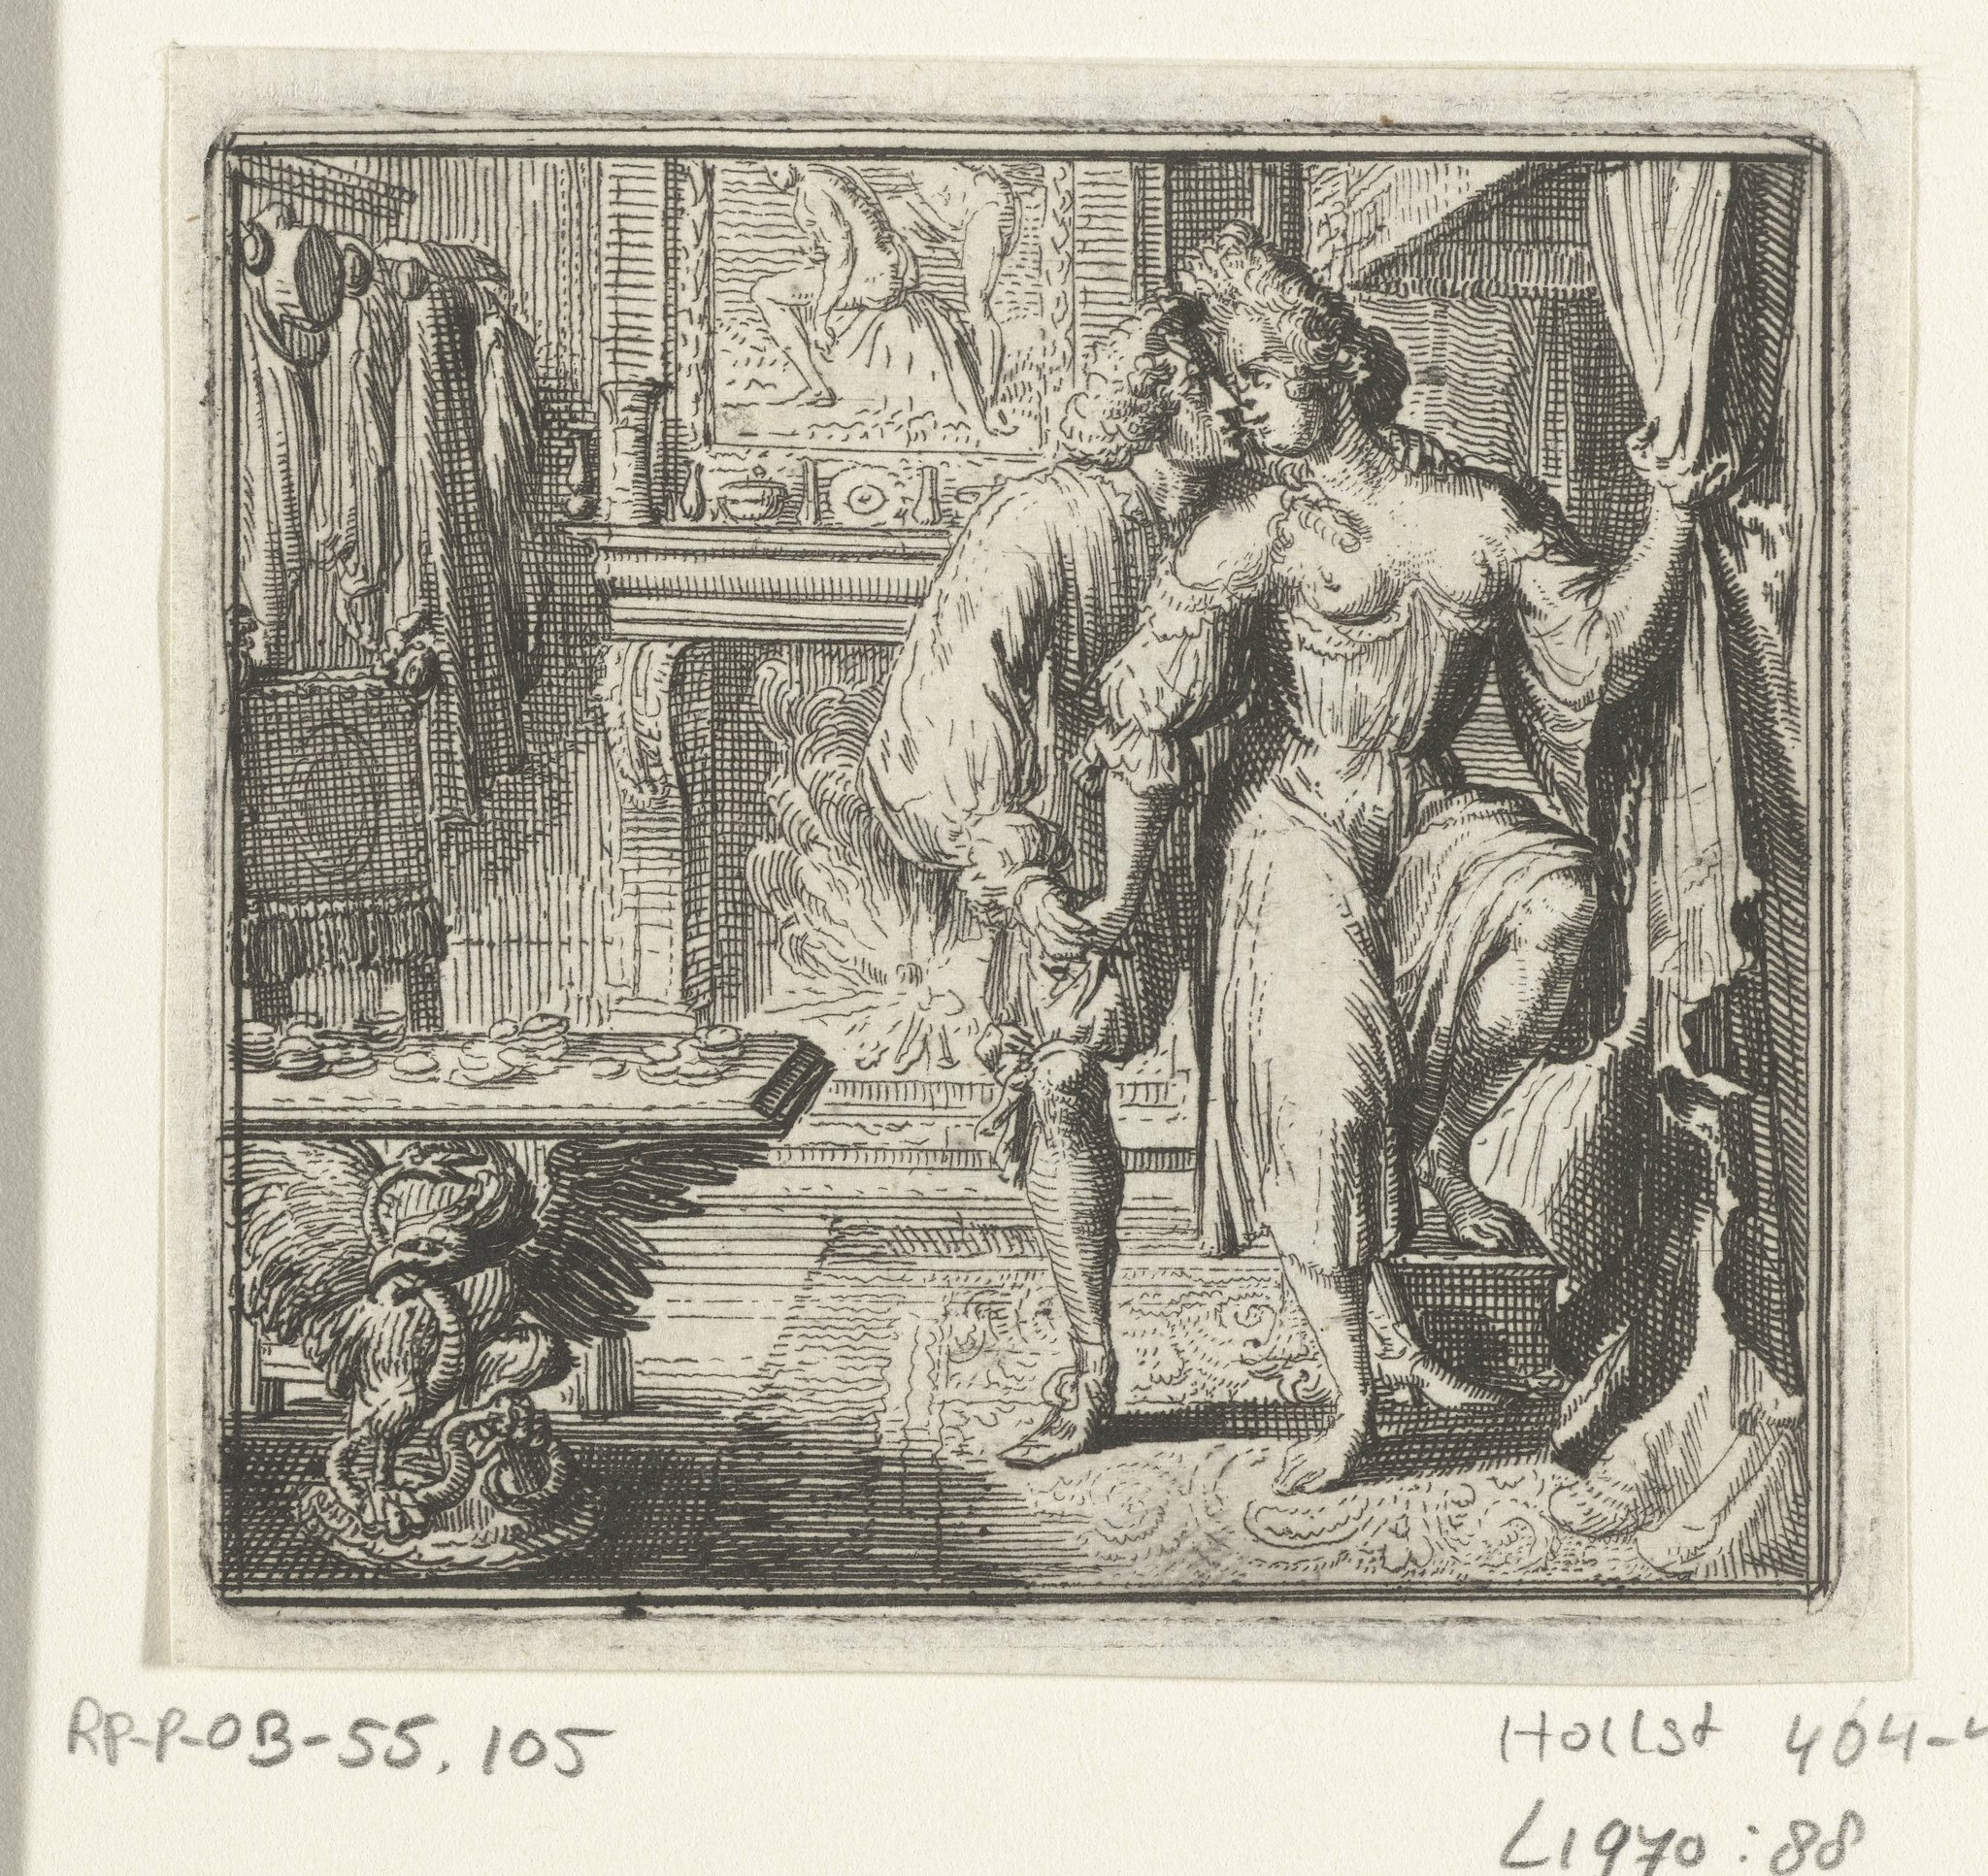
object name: print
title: Illustratie voor de Decamerone van Boccaccio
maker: romeyn de hooghe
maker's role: draughtsman, goldsmith, painter, print maker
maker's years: 1645-1708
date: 1697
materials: paper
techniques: etching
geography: netherlands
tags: (scenes from) specific works of literature: boccaccio, decamerone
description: Illustratie voor de Decamerone van Boccaccio, historie LXXI. De vrouw van Gasparino en haar minnaar Gulsar staan bij het bed. Op tafel liggen de muntstukken die Gulsar betaald heeft.